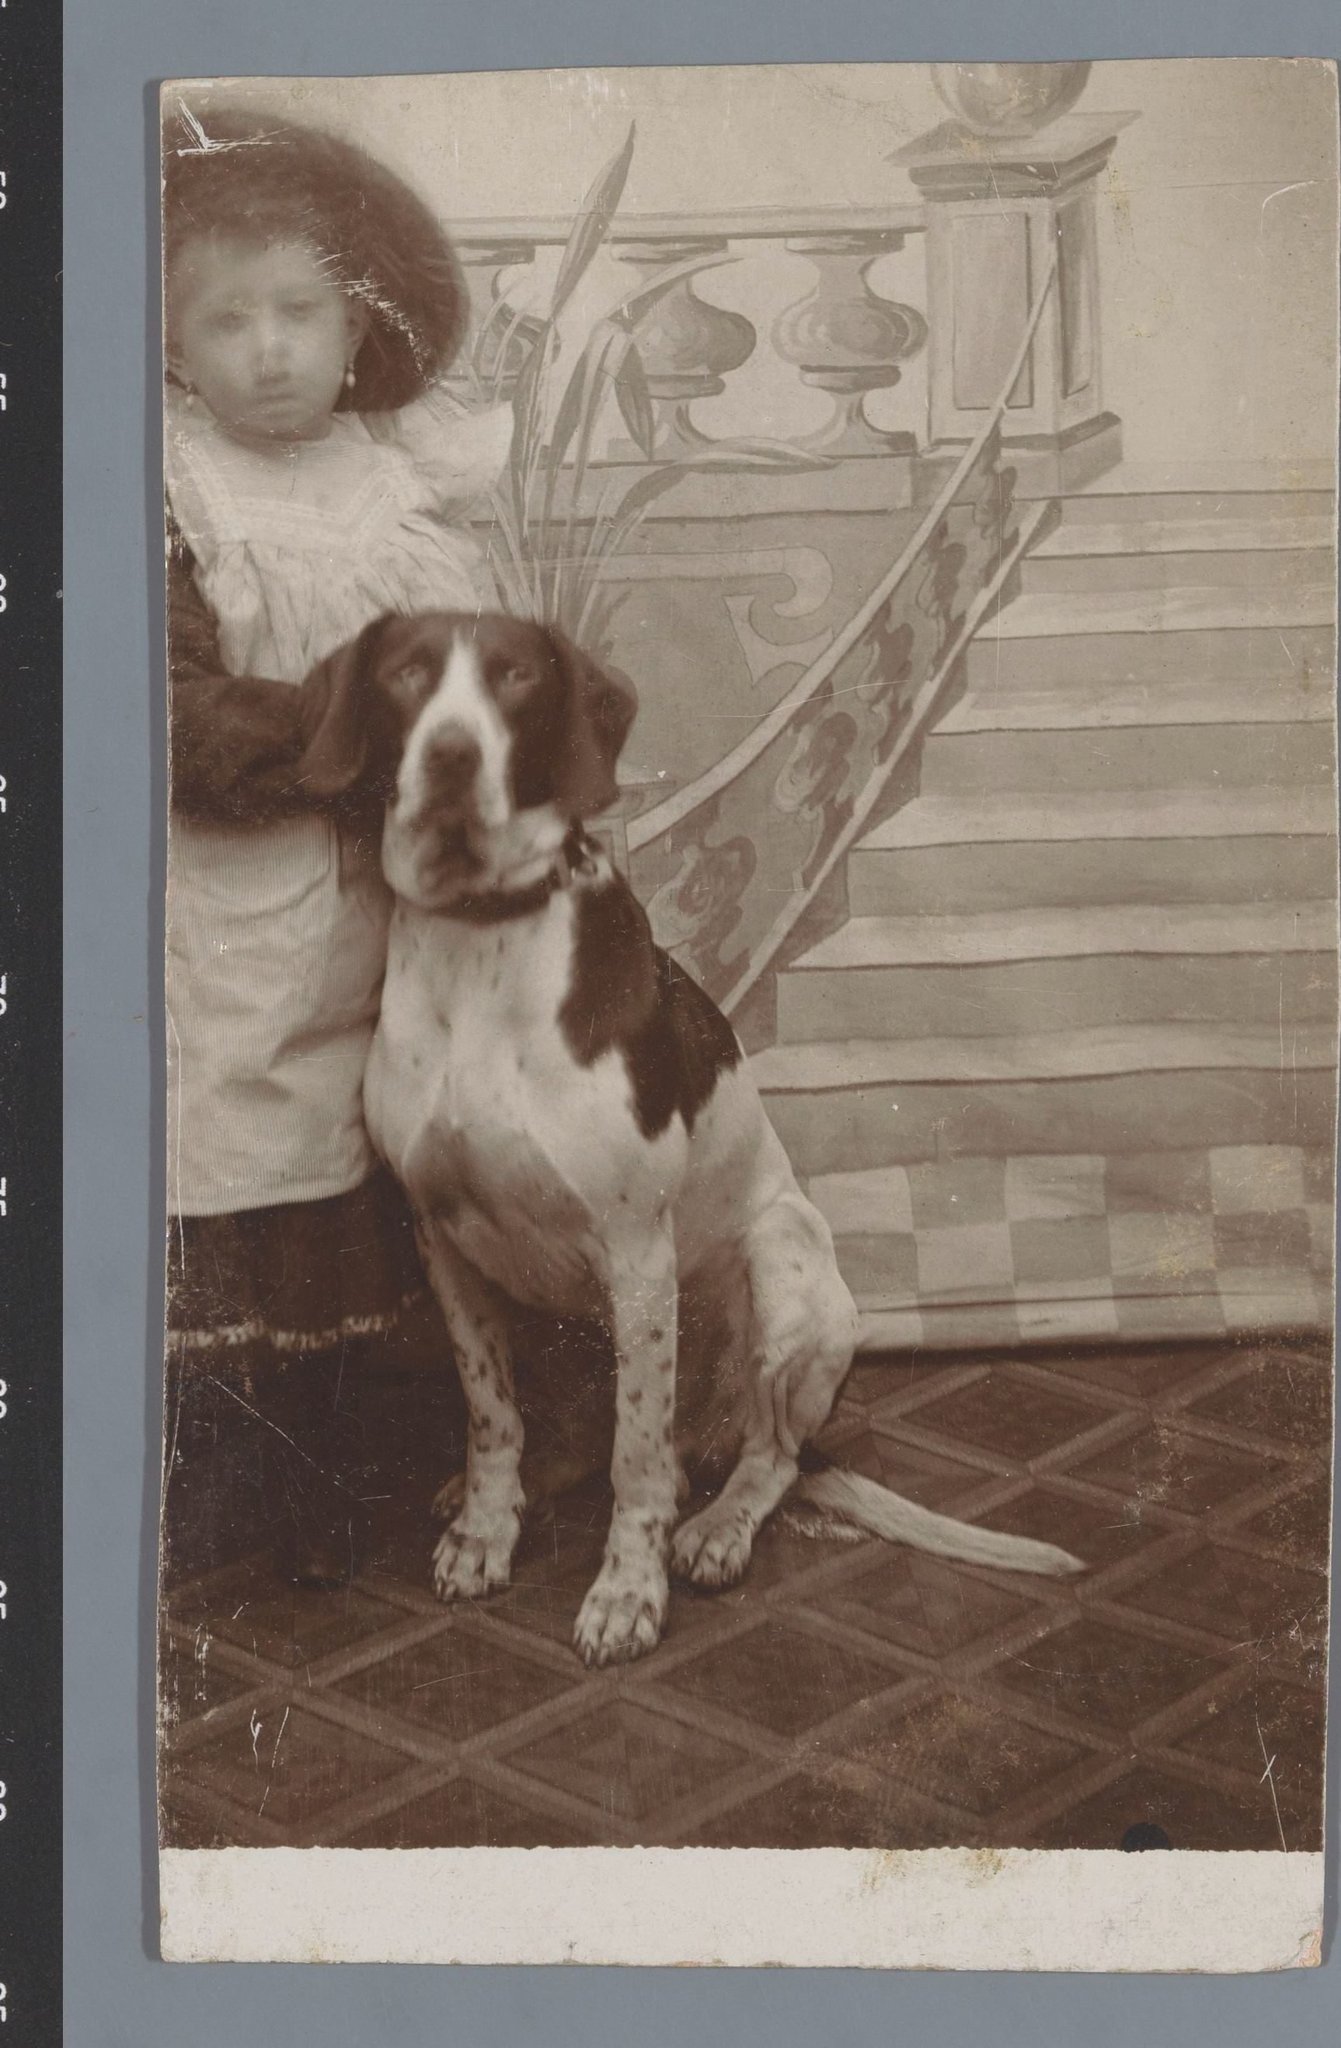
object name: photograph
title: Portret van een onbekend kind met een hond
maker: Anonymous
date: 1905-1915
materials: photographic support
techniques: snipping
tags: studio requisites ~ photographer, child, dog